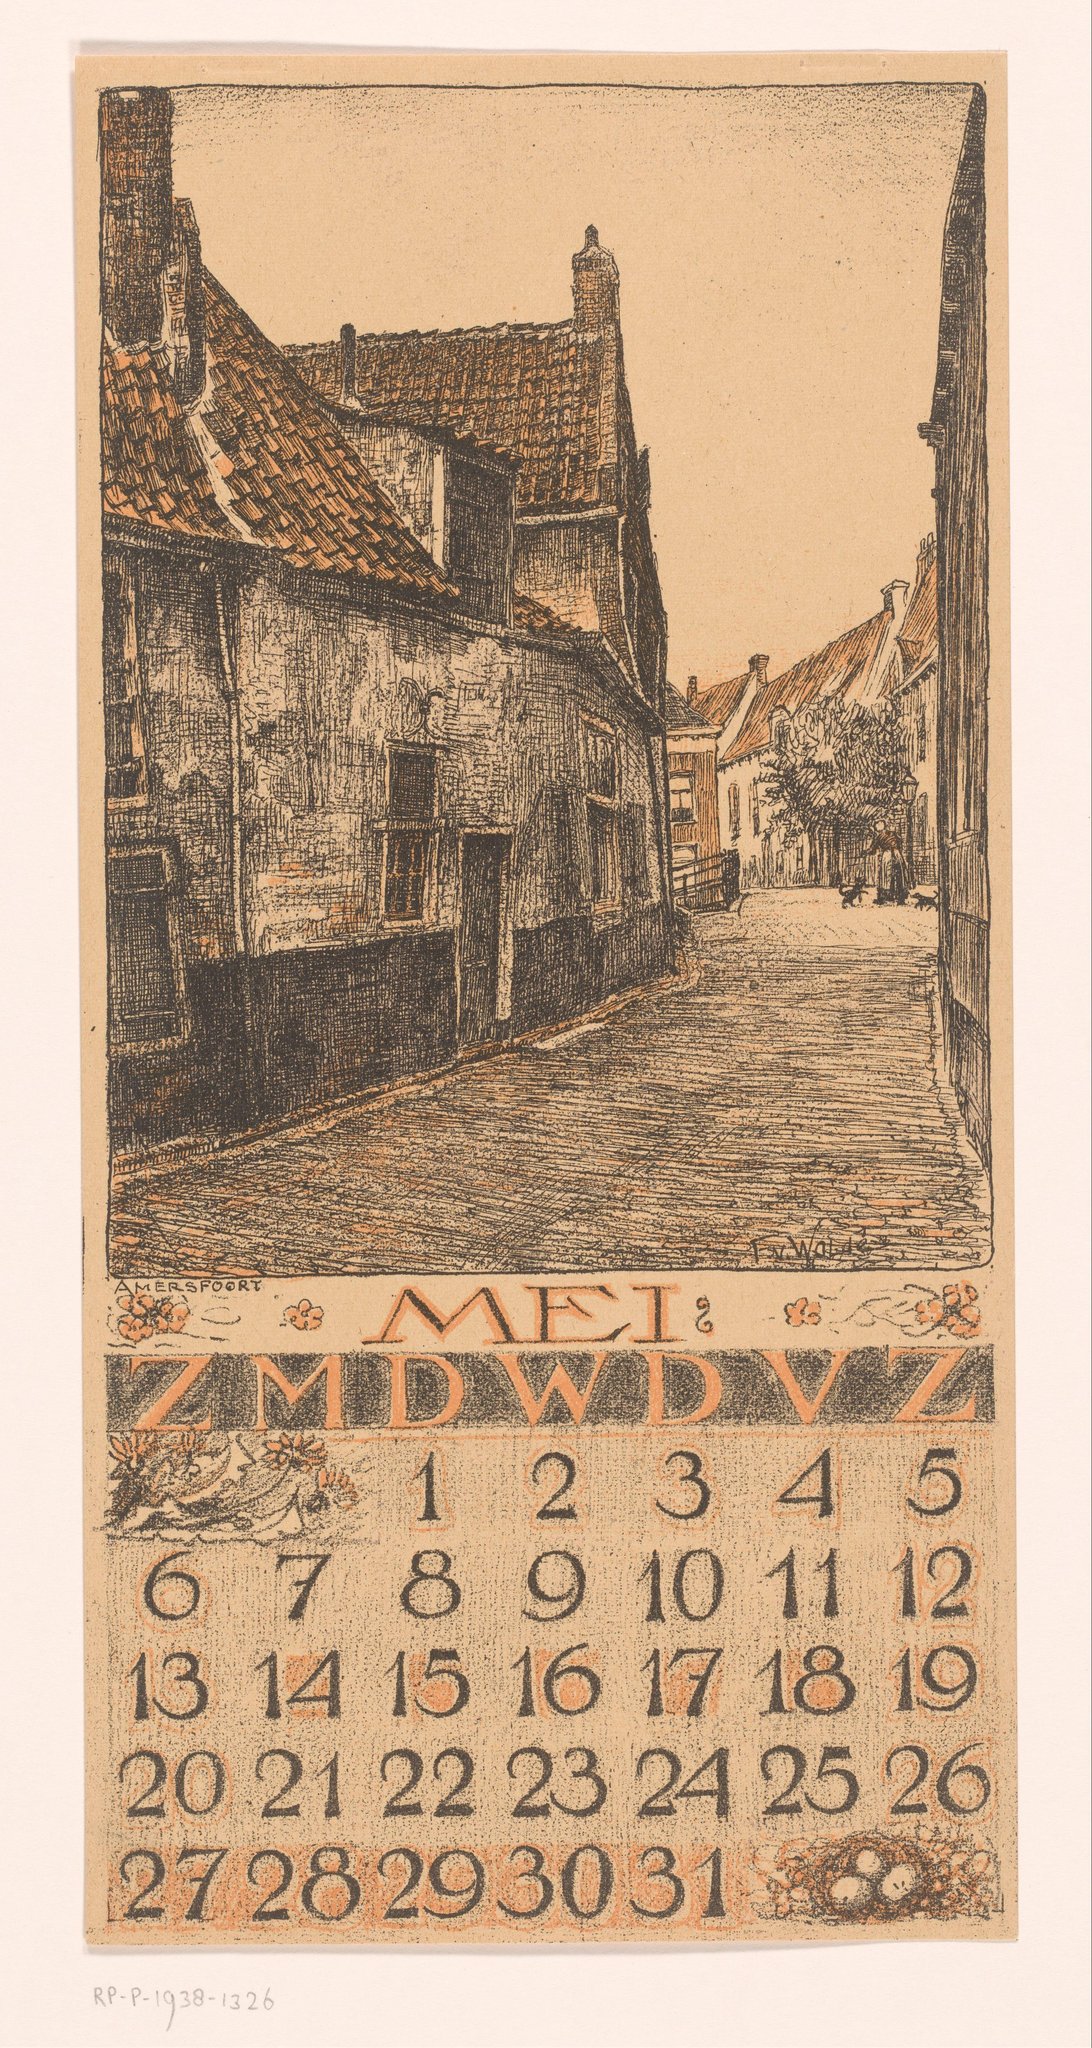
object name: calendar leaf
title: Kalenderblad mei met stadsgezicht in Amersfoort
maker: ferdinand van wolde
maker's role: print maker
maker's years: 1891-1945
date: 1923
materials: paper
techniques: lithograph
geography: netherlands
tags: may ~ other concepts, street (+ city(-scape) with figures, staffage)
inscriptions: collector's mark: Lugt 2228, collector's mark: Lugt 2760